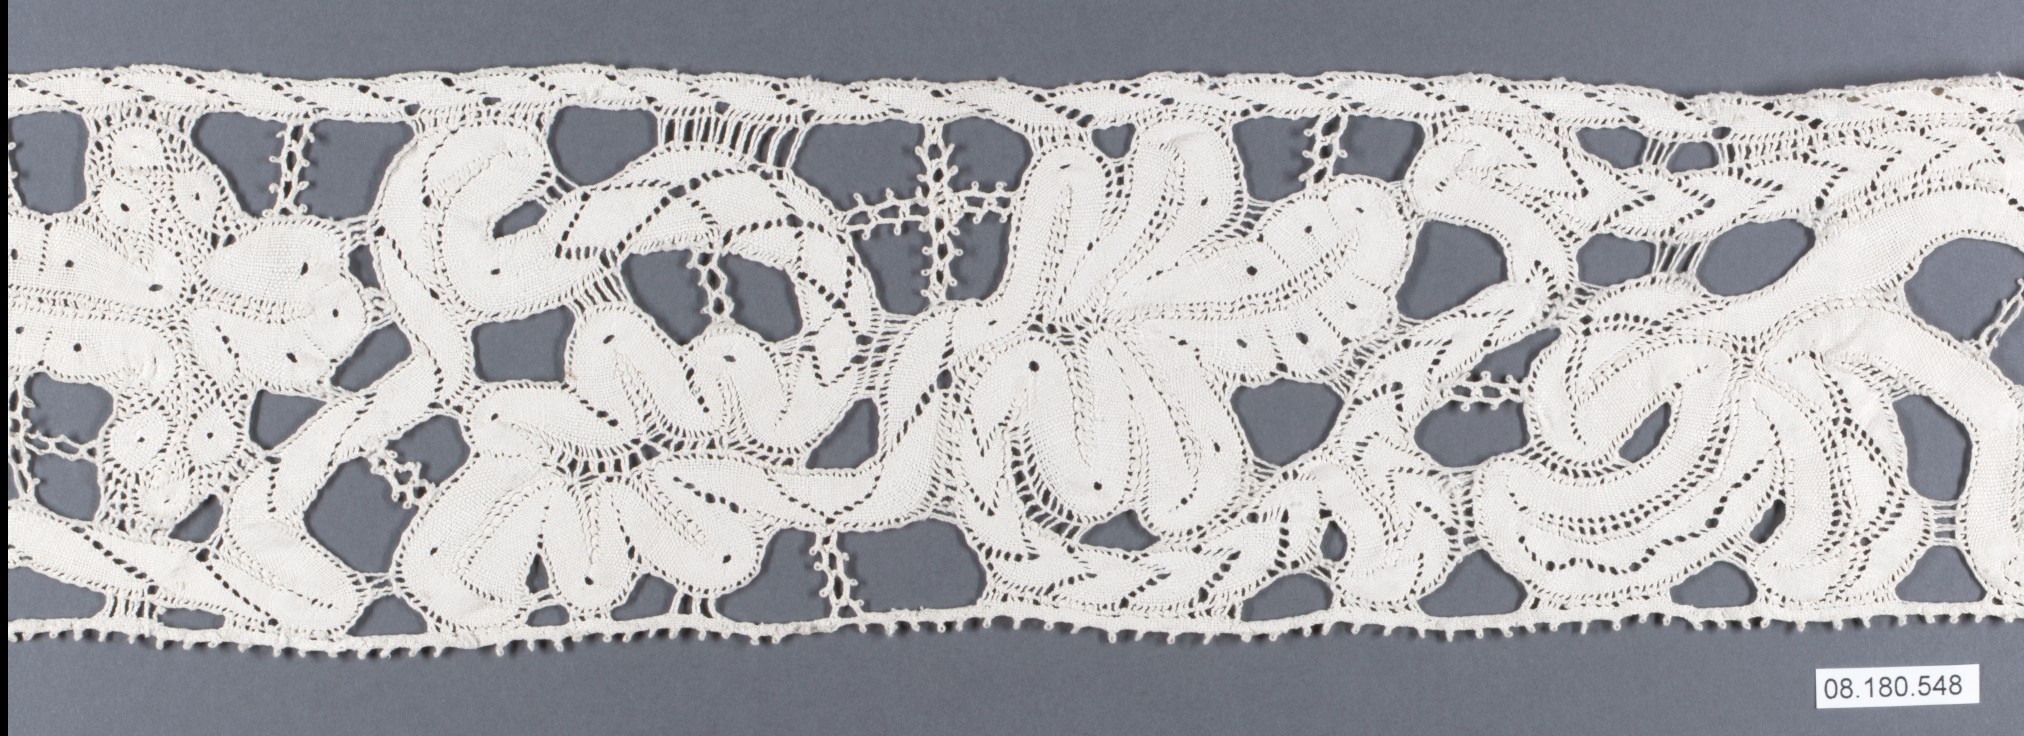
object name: fragment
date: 1601-1700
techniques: lace